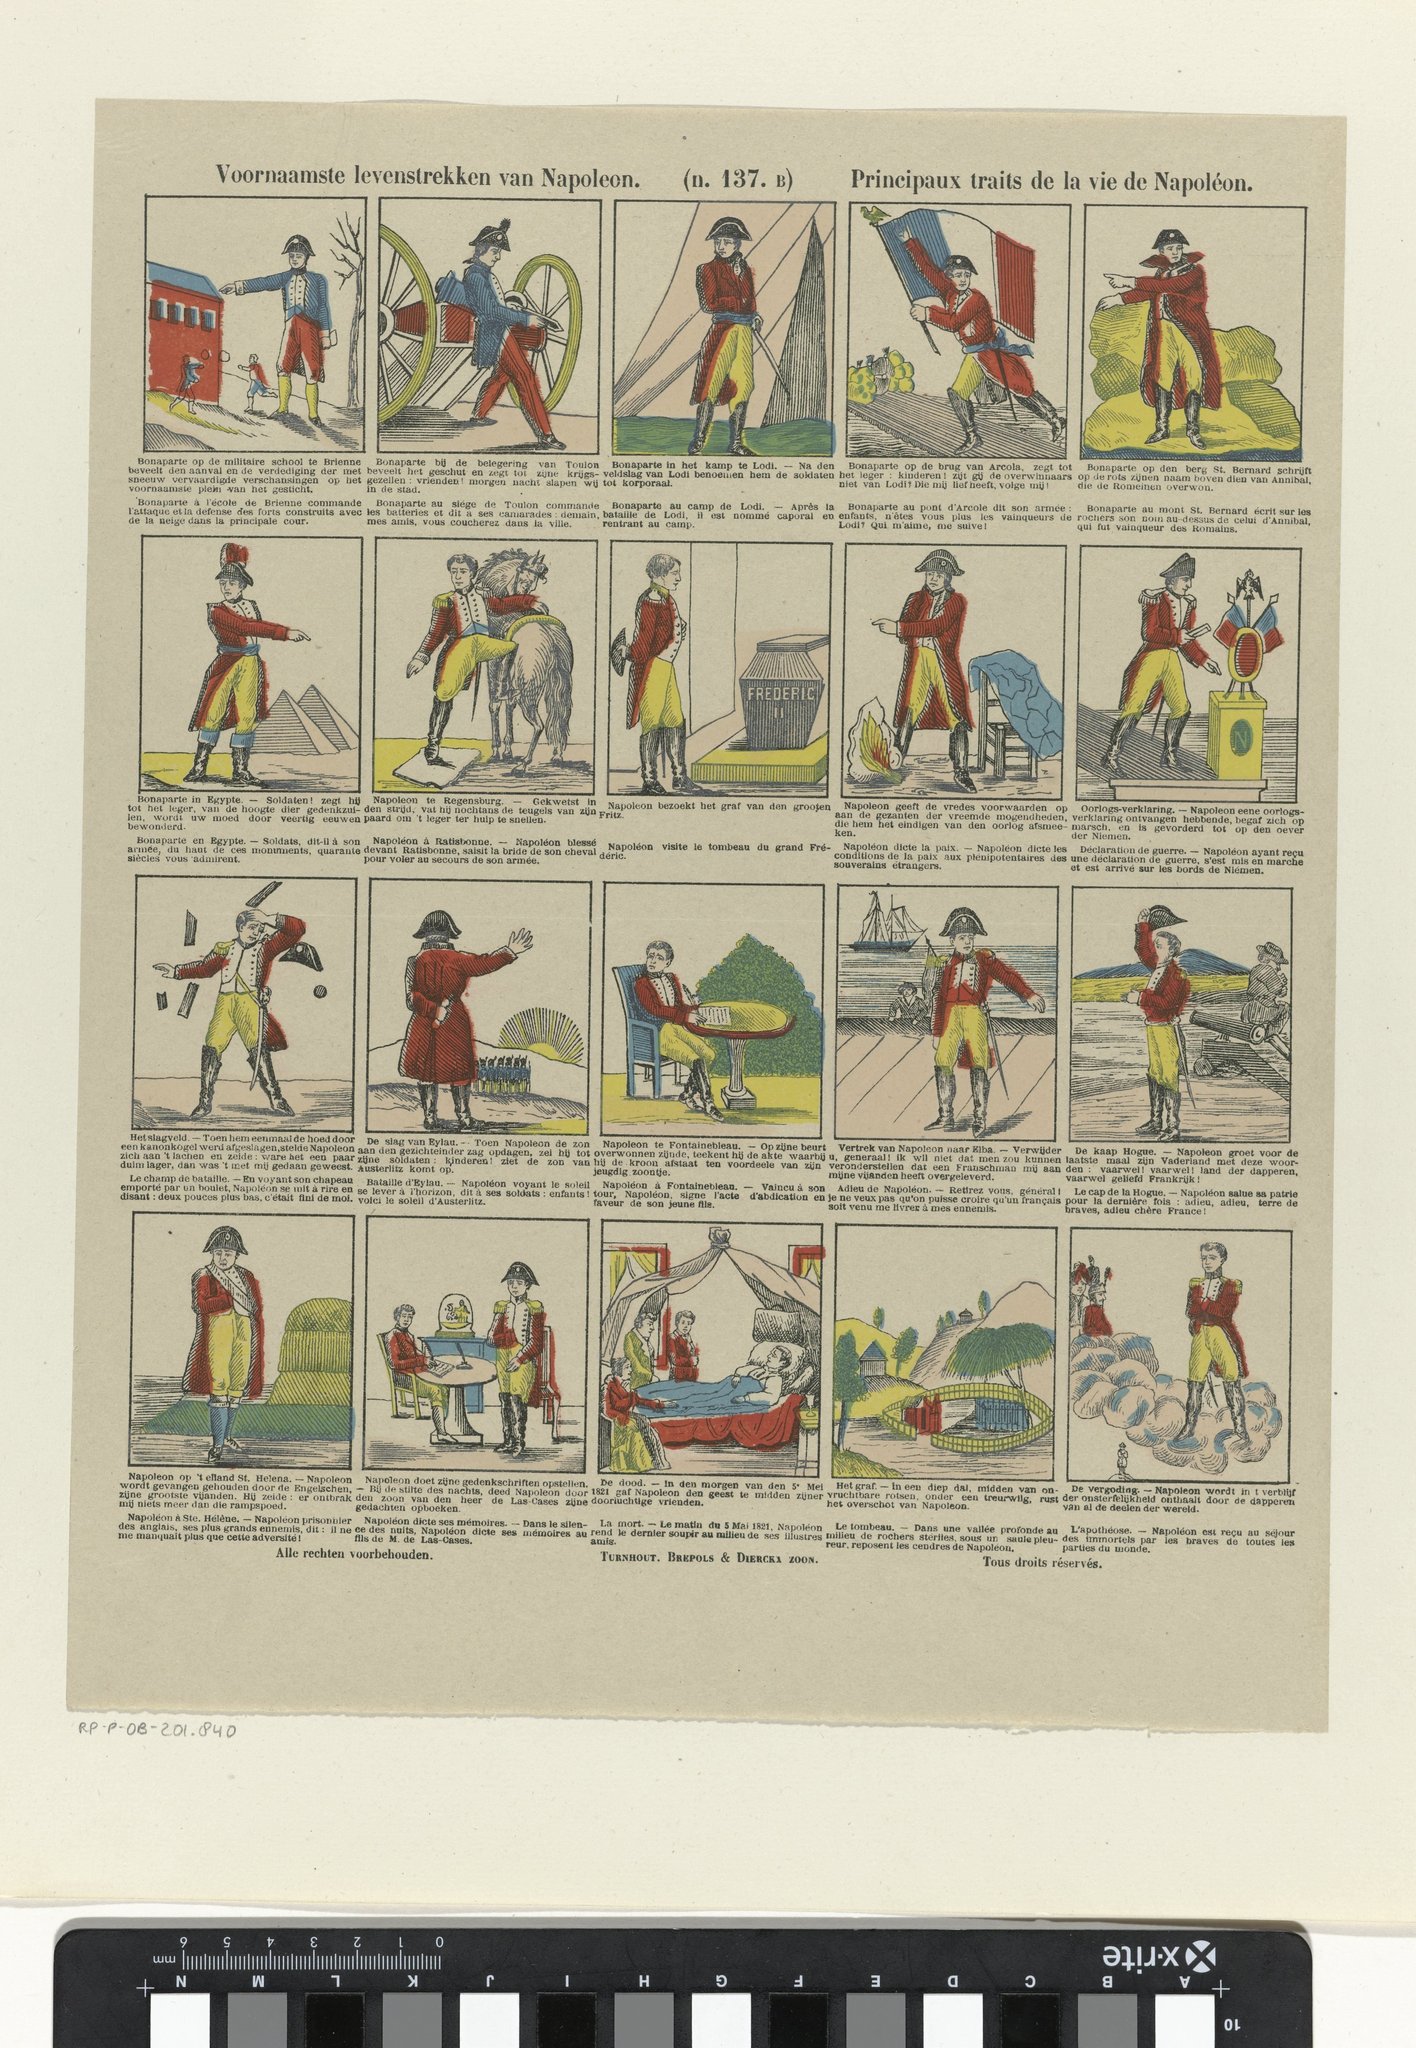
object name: popular print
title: Voornaamste levenstrekken van Napoleon / Principaux traits de la vie de Napoléon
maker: Anonymous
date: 1833-1911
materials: paper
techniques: lithograph, letterpress printing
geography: turnhout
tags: napoleon i (emperor of the french)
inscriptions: collector's mark: Lugt 2760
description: Blad met 20 voorstellingen over het leven van Napoleon. Onder elke afbeelding een onderschrift in het Nederlands en in het Frans. Genummerd midden boven: (n. 137. B).